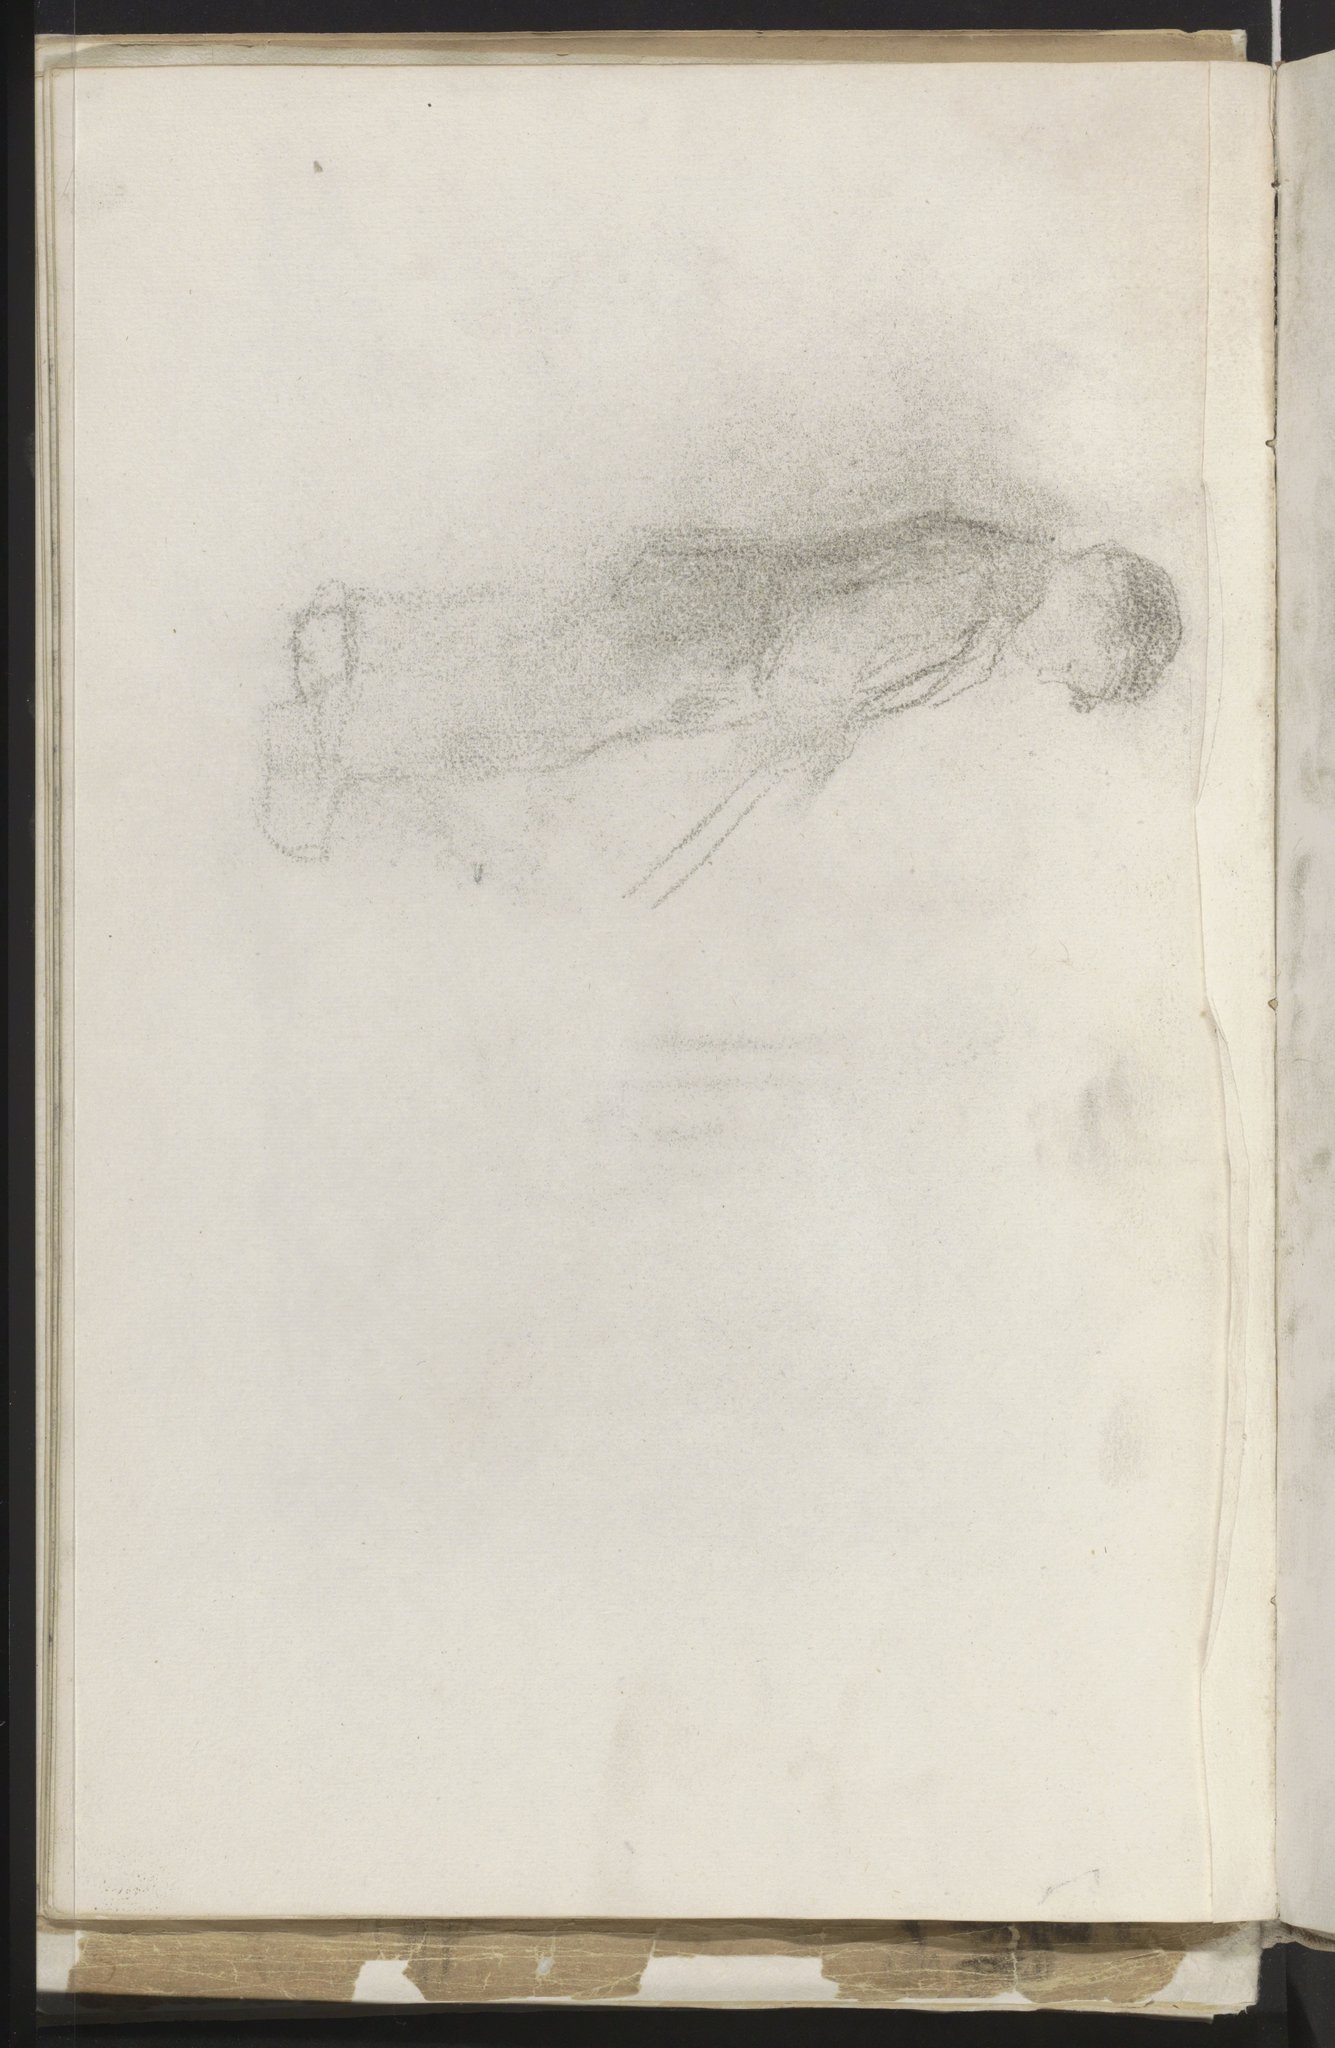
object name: sketchbook leaf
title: Boerenjongen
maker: albert neuhuys (1844-1914)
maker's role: draughtsman, painter, print maker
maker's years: 1844-1914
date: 1854-1914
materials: charcoal, paper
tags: boy (child between toddler and youth), wooden shoes, clogs, farmers, agricultural implements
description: De jongen houdt een landbouwwerktuig vast. Blad 41 verso uit een schetsboek met 53 bladen.